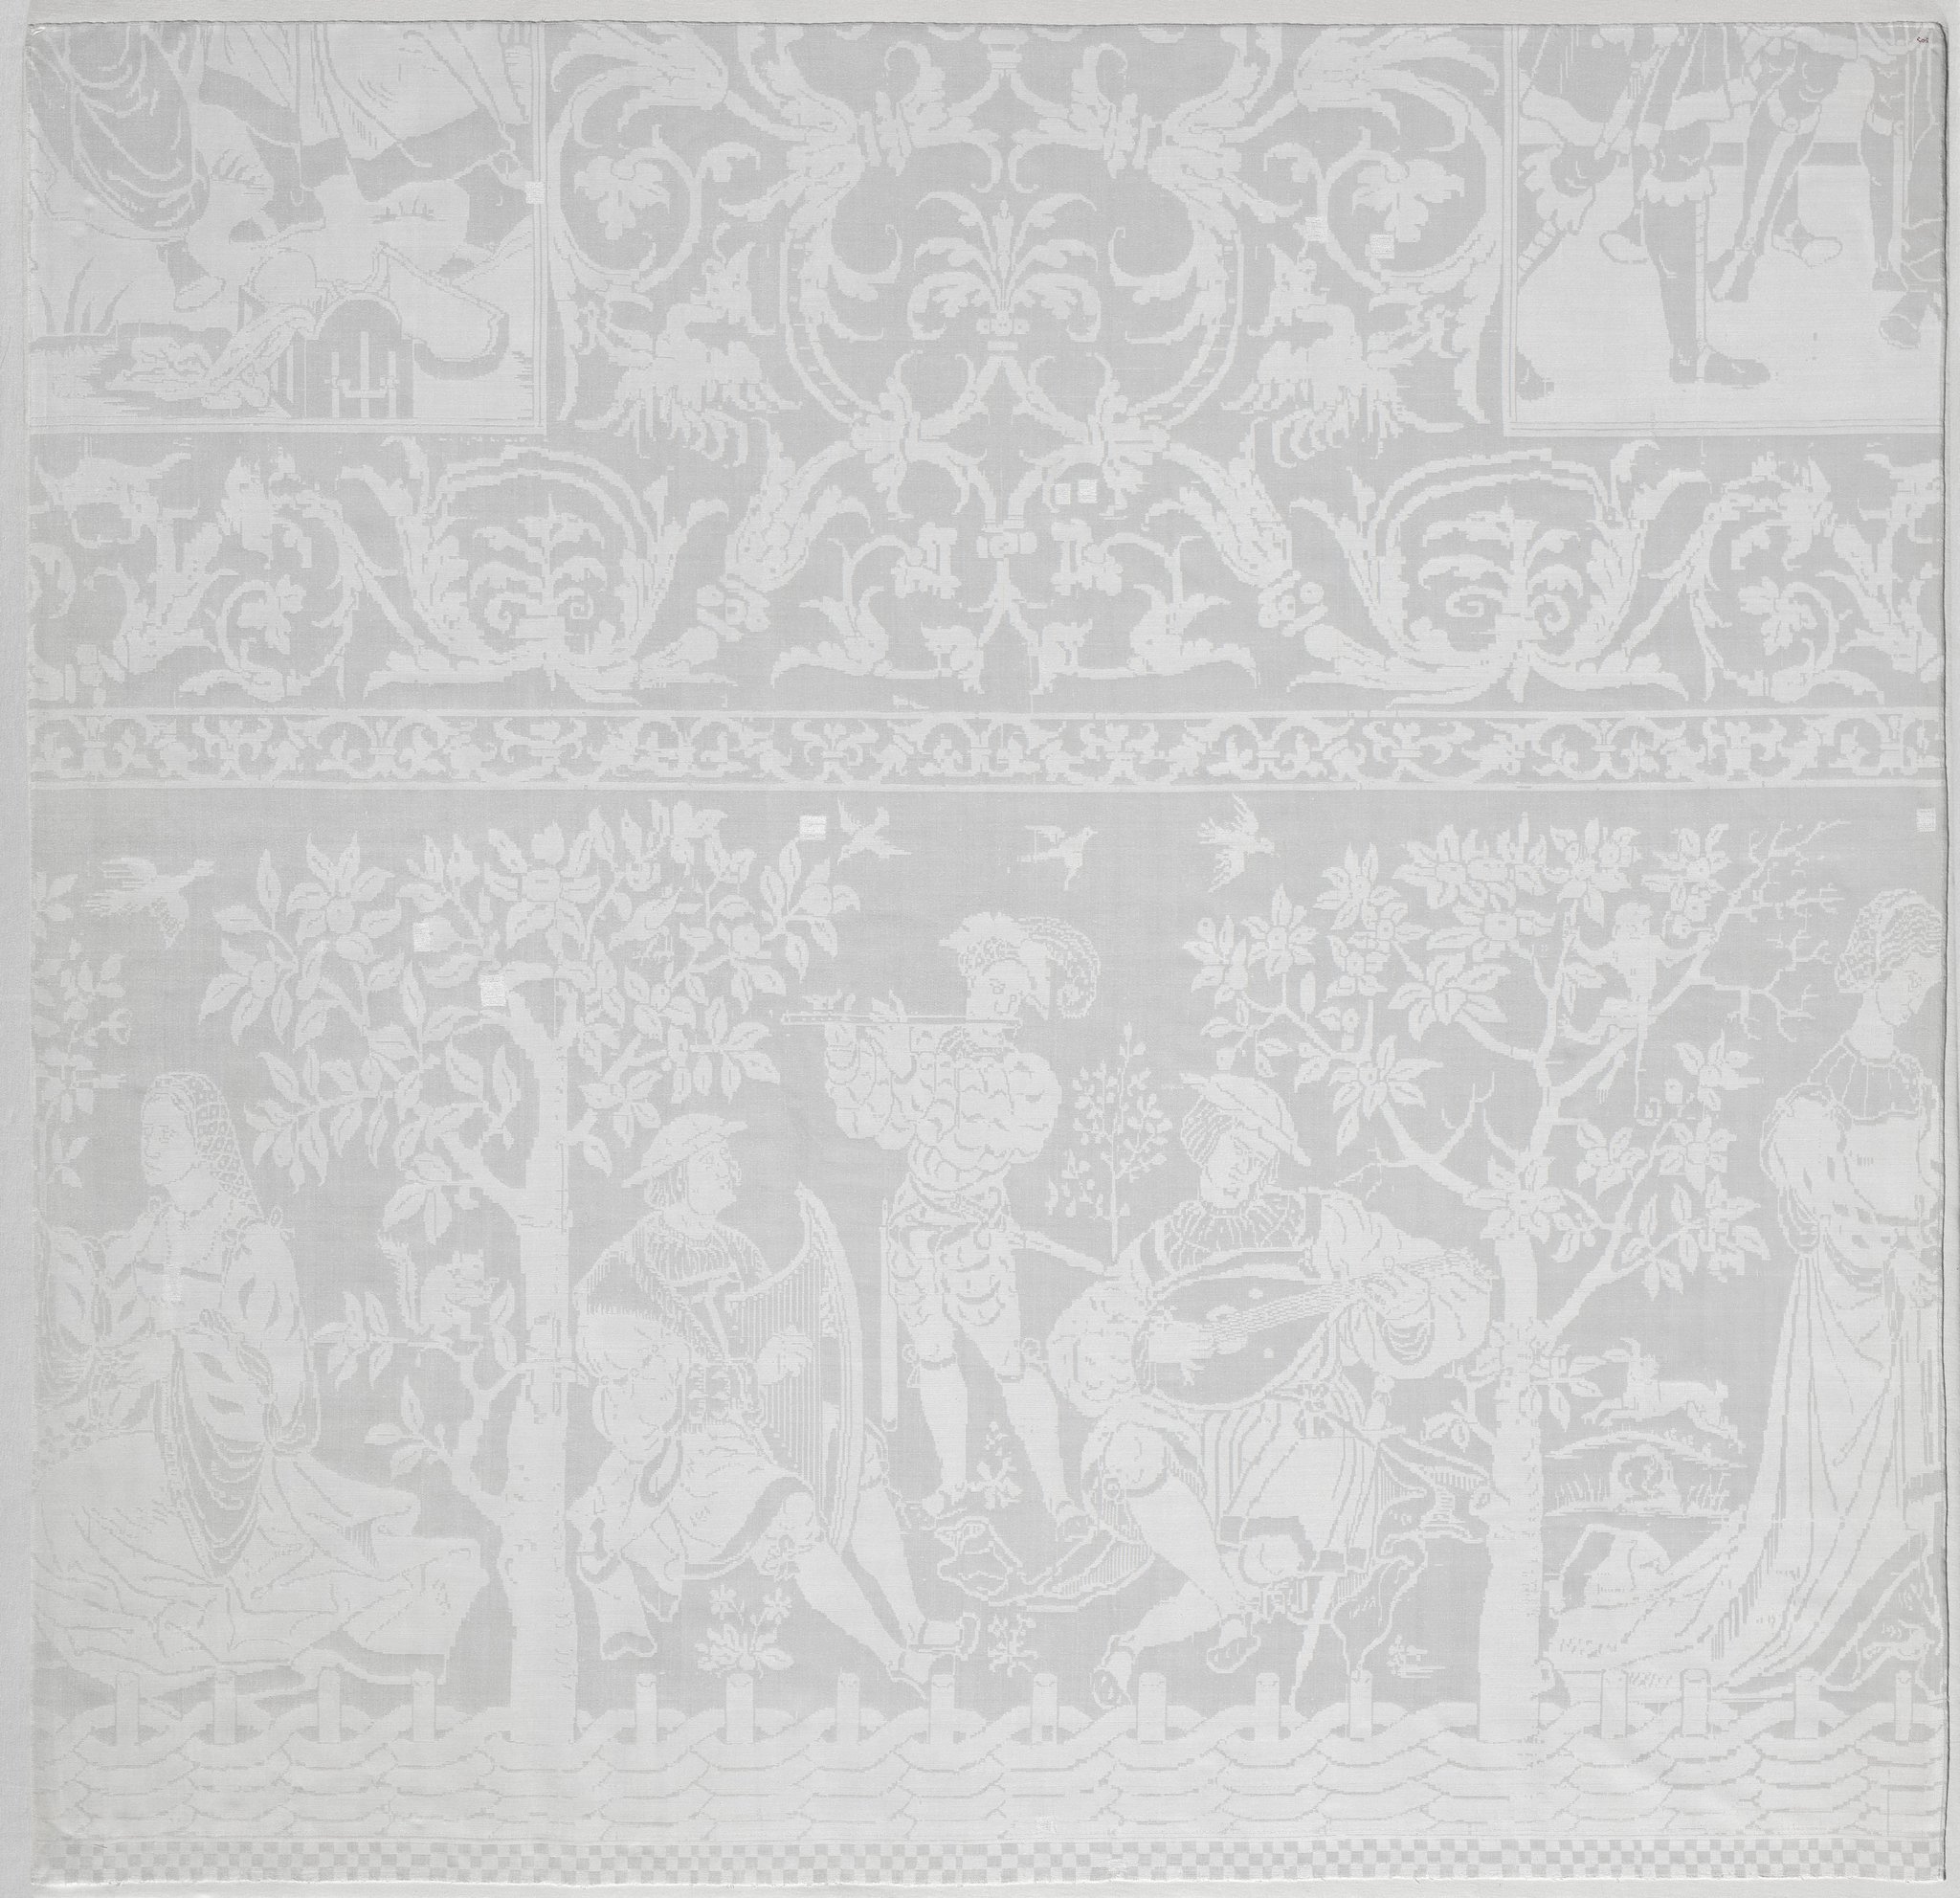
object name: fragment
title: Fragment van een tafellaken van linnendamast met voorstelling: geschiedenis van Susanna; rand met muzikanten en vrouwen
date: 1531-1540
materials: linen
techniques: damask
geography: southern netherlands